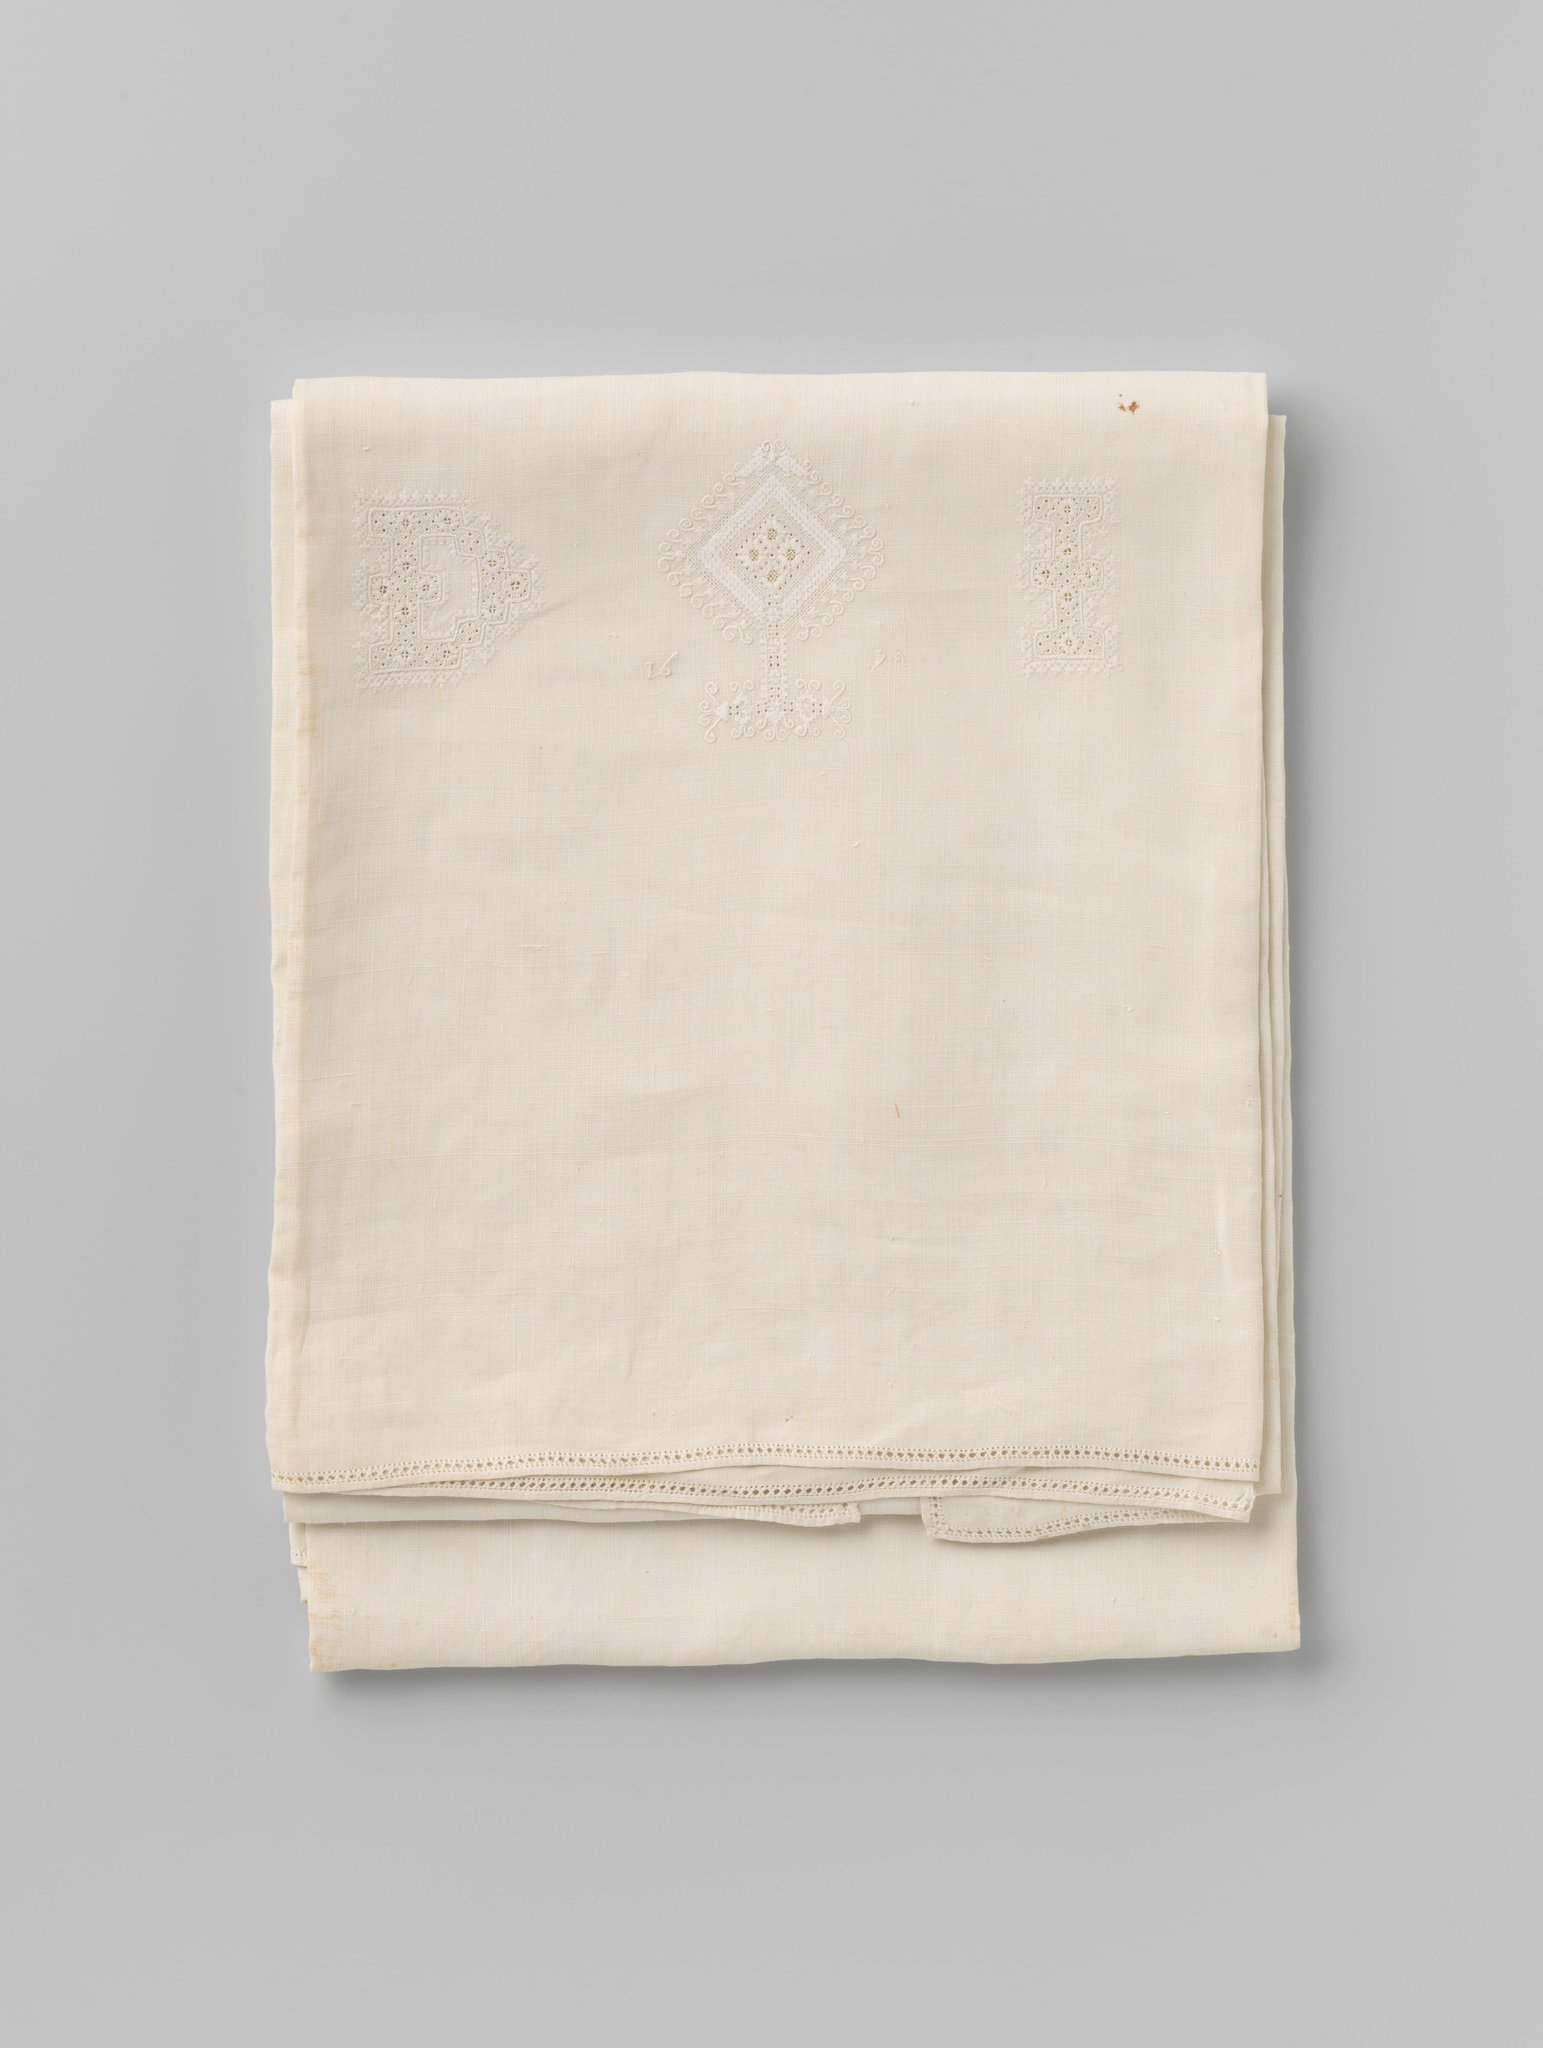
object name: beddenlaken, laken object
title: Laken met entre-deux met fijn ruitpatroon. Merk: initialen D en I ter weerszijden van levensboom(?) en jaartal 1672.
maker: Anonymous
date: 1672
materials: linen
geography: northern netherlands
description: Beddenlaken van linnen met geborduurd jaartal 1672. Twee banen, rondom afgewerkt met open zomen, zijn met een gekloste entre-deux, dat een fijn ruitpatroon vertoont, aan elkaar gezet. Op de bovenomslag van iedere baan is een wit borduursel aangebracht, o.a. in fils lirés, in de vorm van grote uitvoerig gewerkte initialen D en I, ter weerszijden van een levensboom (?). In een fijne steelsteek is het jaartal 1672 aangebracht. Ettelijke roestvlekjes.